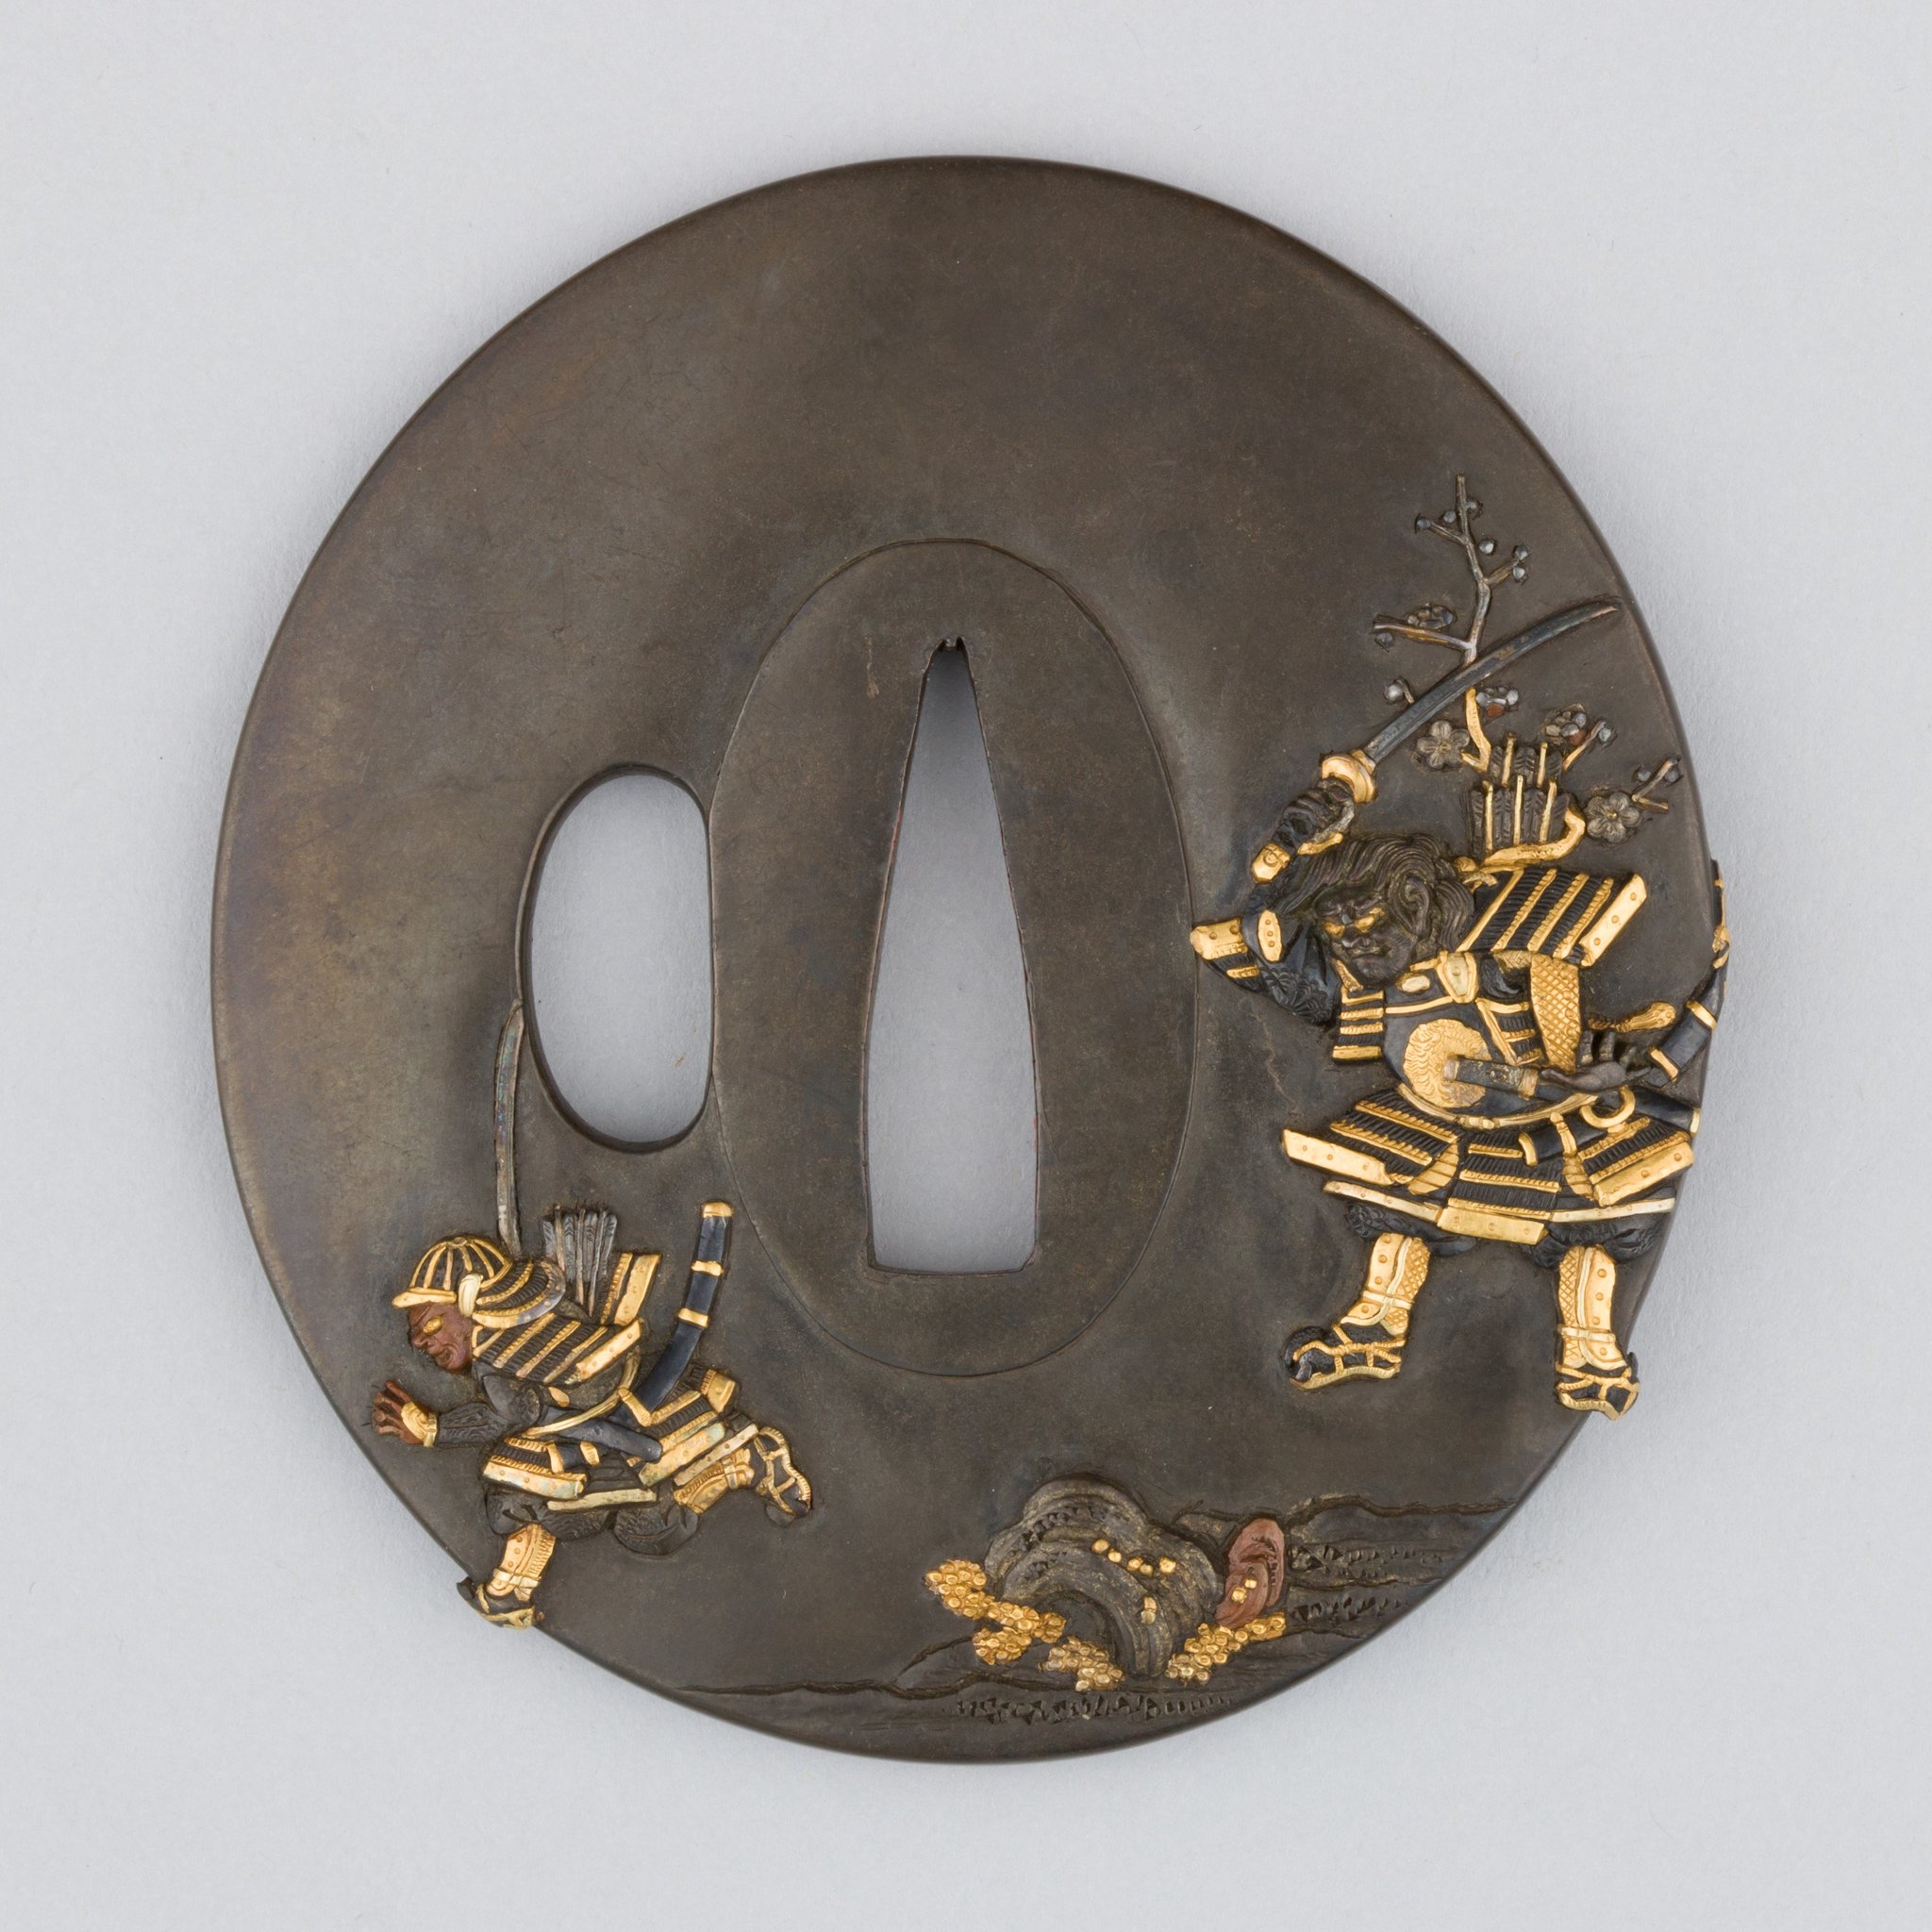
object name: sword guard tsuba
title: Sword Guard (Tsuba)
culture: japanese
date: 1701-1800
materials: copper, gold alloy, gold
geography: japan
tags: men